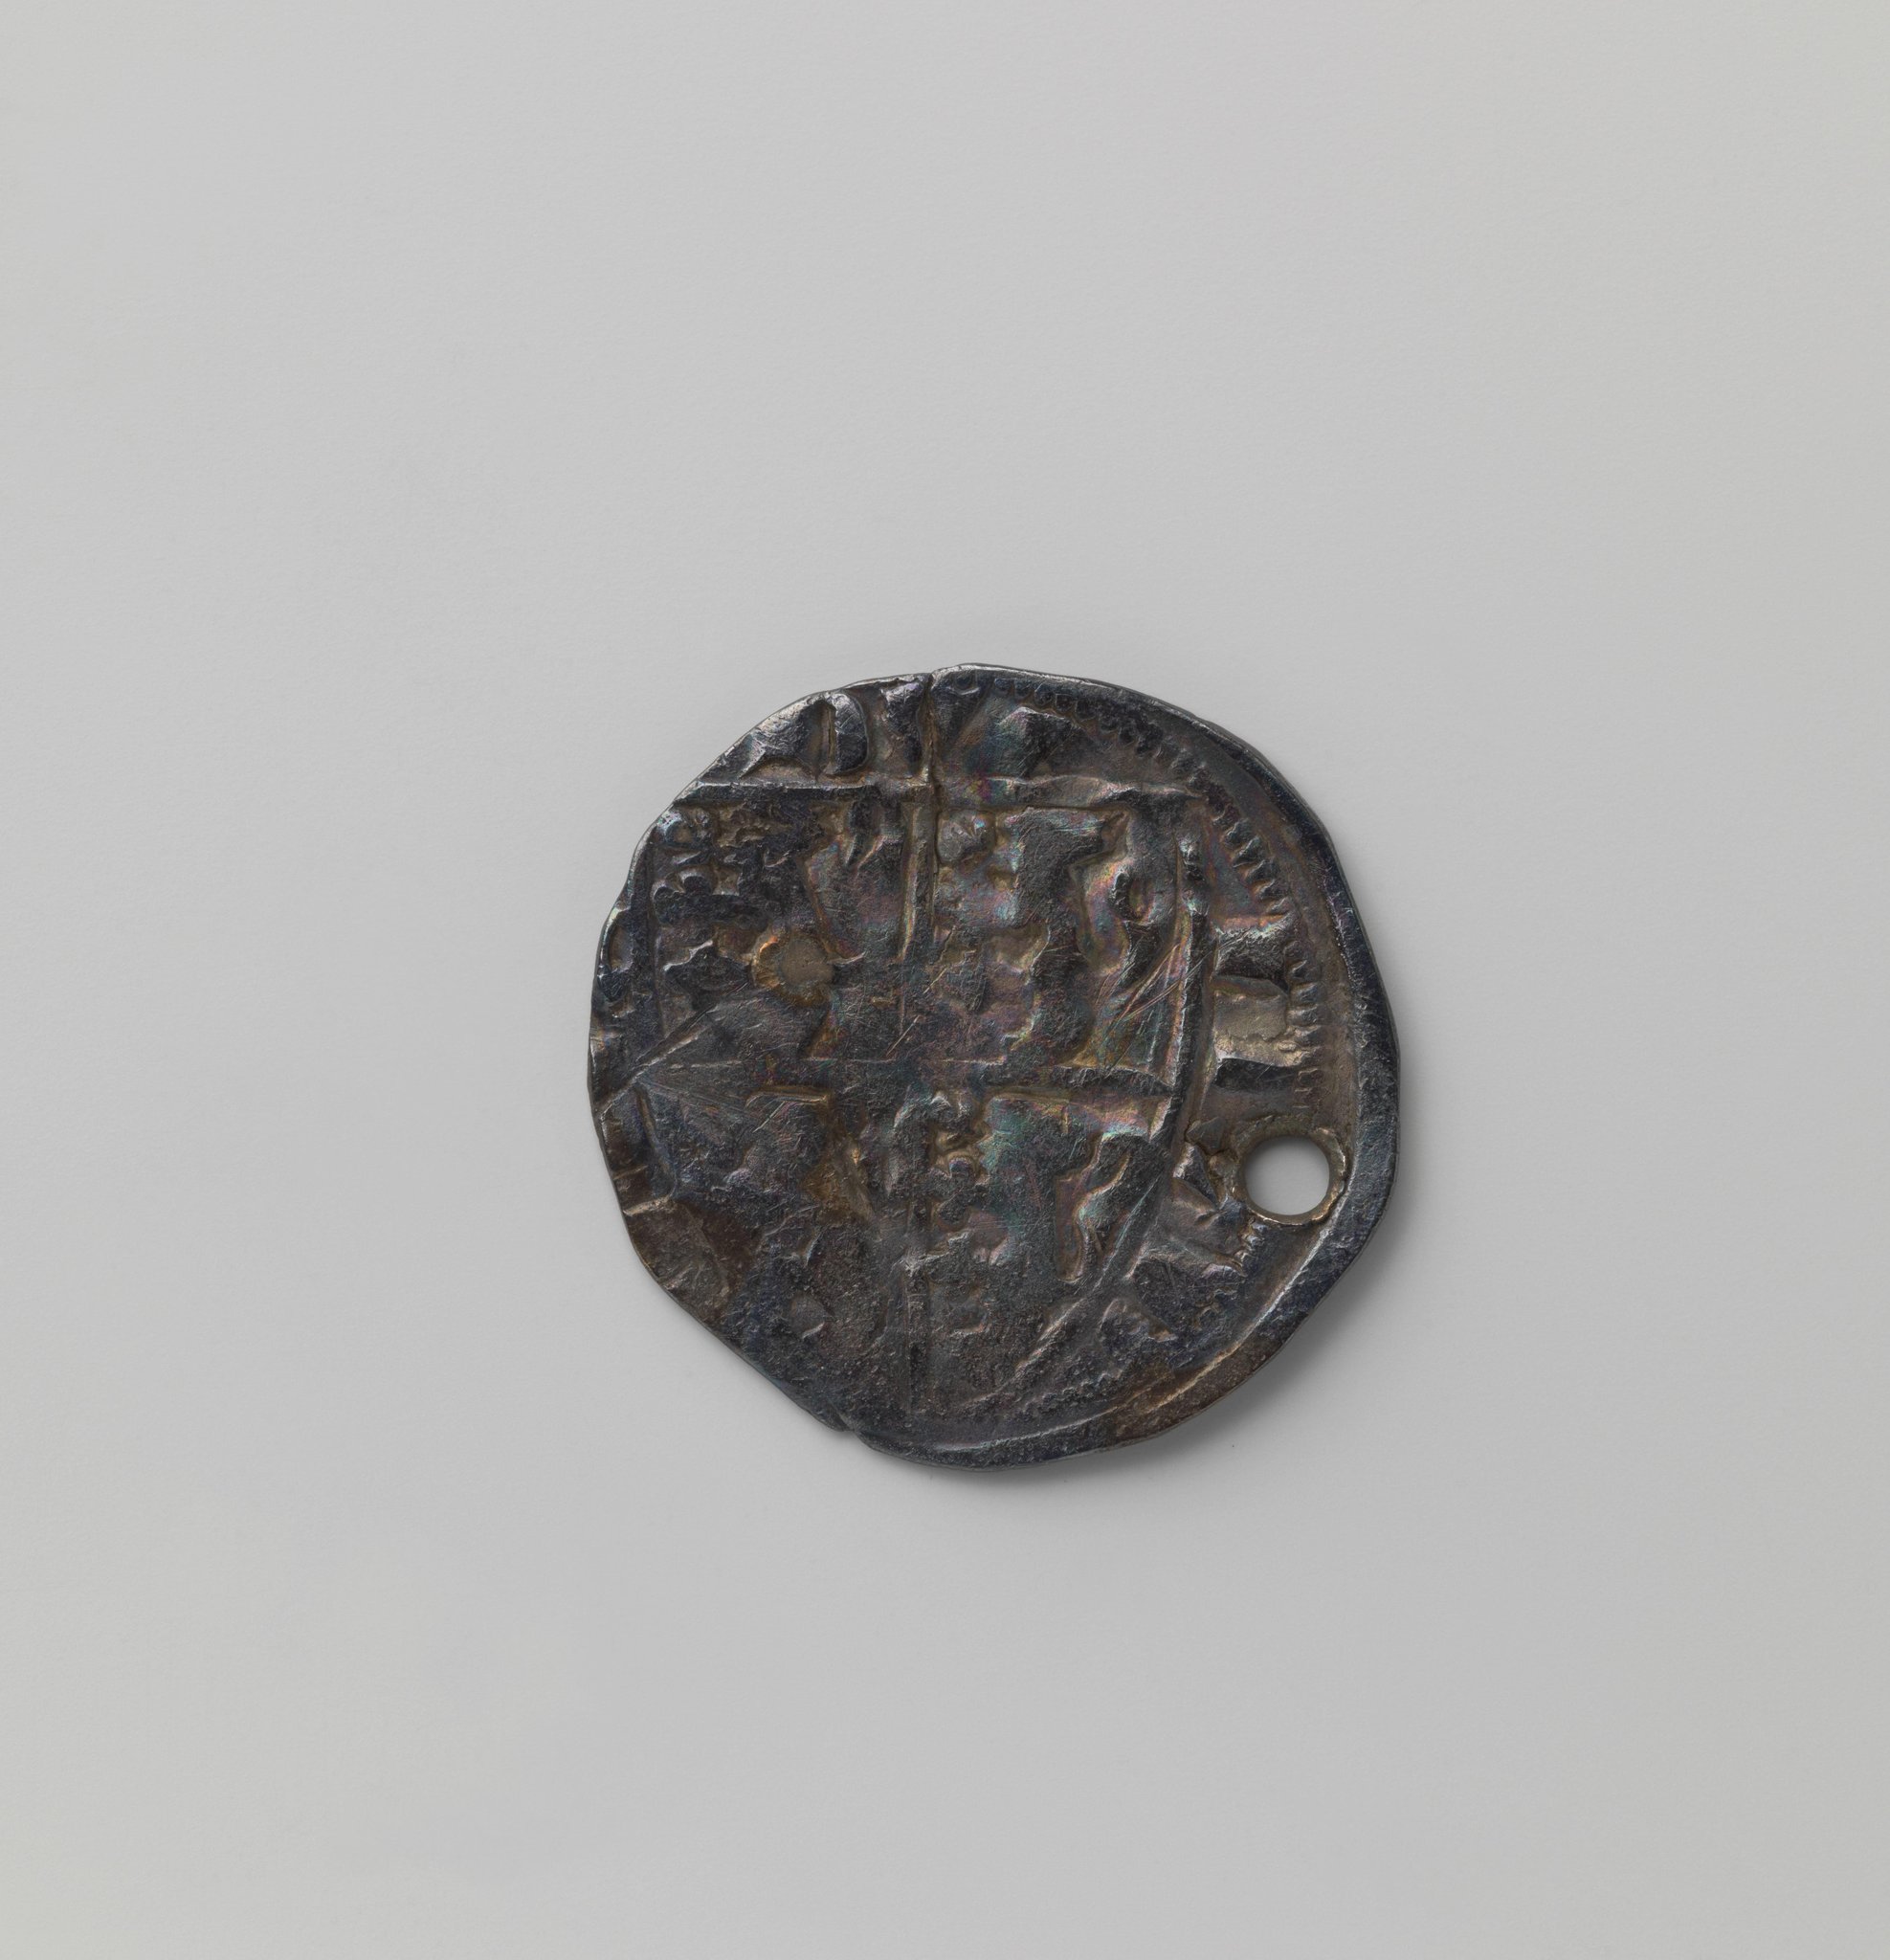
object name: coin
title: Brabant, Jan III, sterling brabantinus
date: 1330-1337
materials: silver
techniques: striking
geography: leuven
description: Voorzijde: in een punt uitlopend gecombineerd Brabants/Limburgs wapenschild, waaromheen omschrift. Keerzijde: kort gebloemd kruis. Daaromheen omschrift MONETA LOVANES. Gaatje in munt.